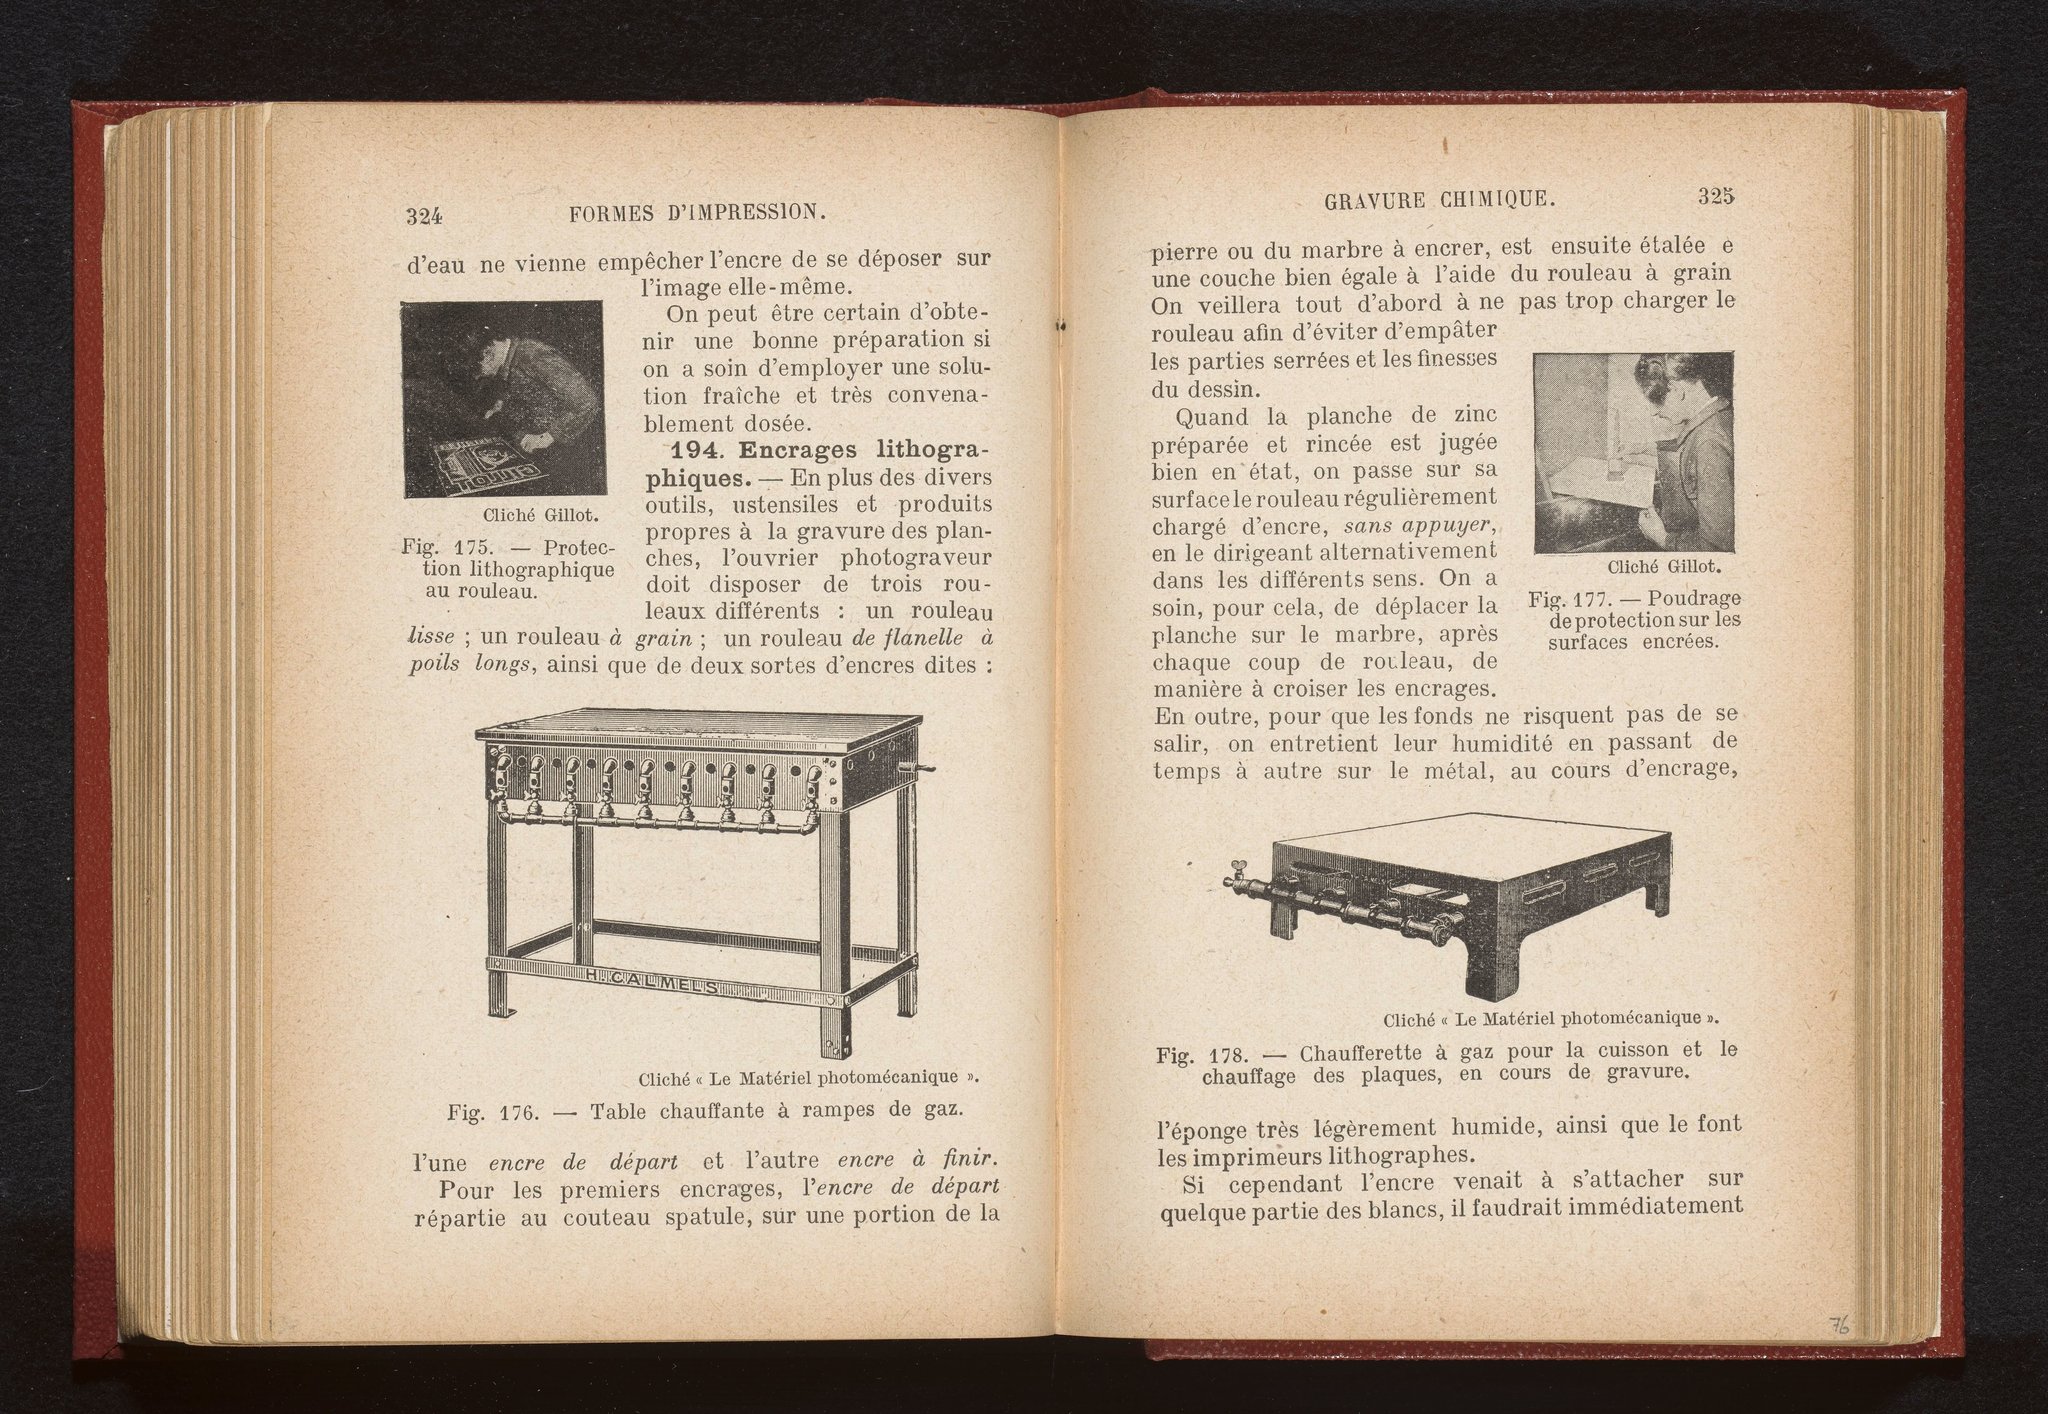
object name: photomechanical print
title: Protection lithographique au rouleau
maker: Anonymous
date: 1922-1932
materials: paper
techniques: autotype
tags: print, e.g.: engraving, etching, lithograph, photographic apparatus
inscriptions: number: ‘Fig. 175.’